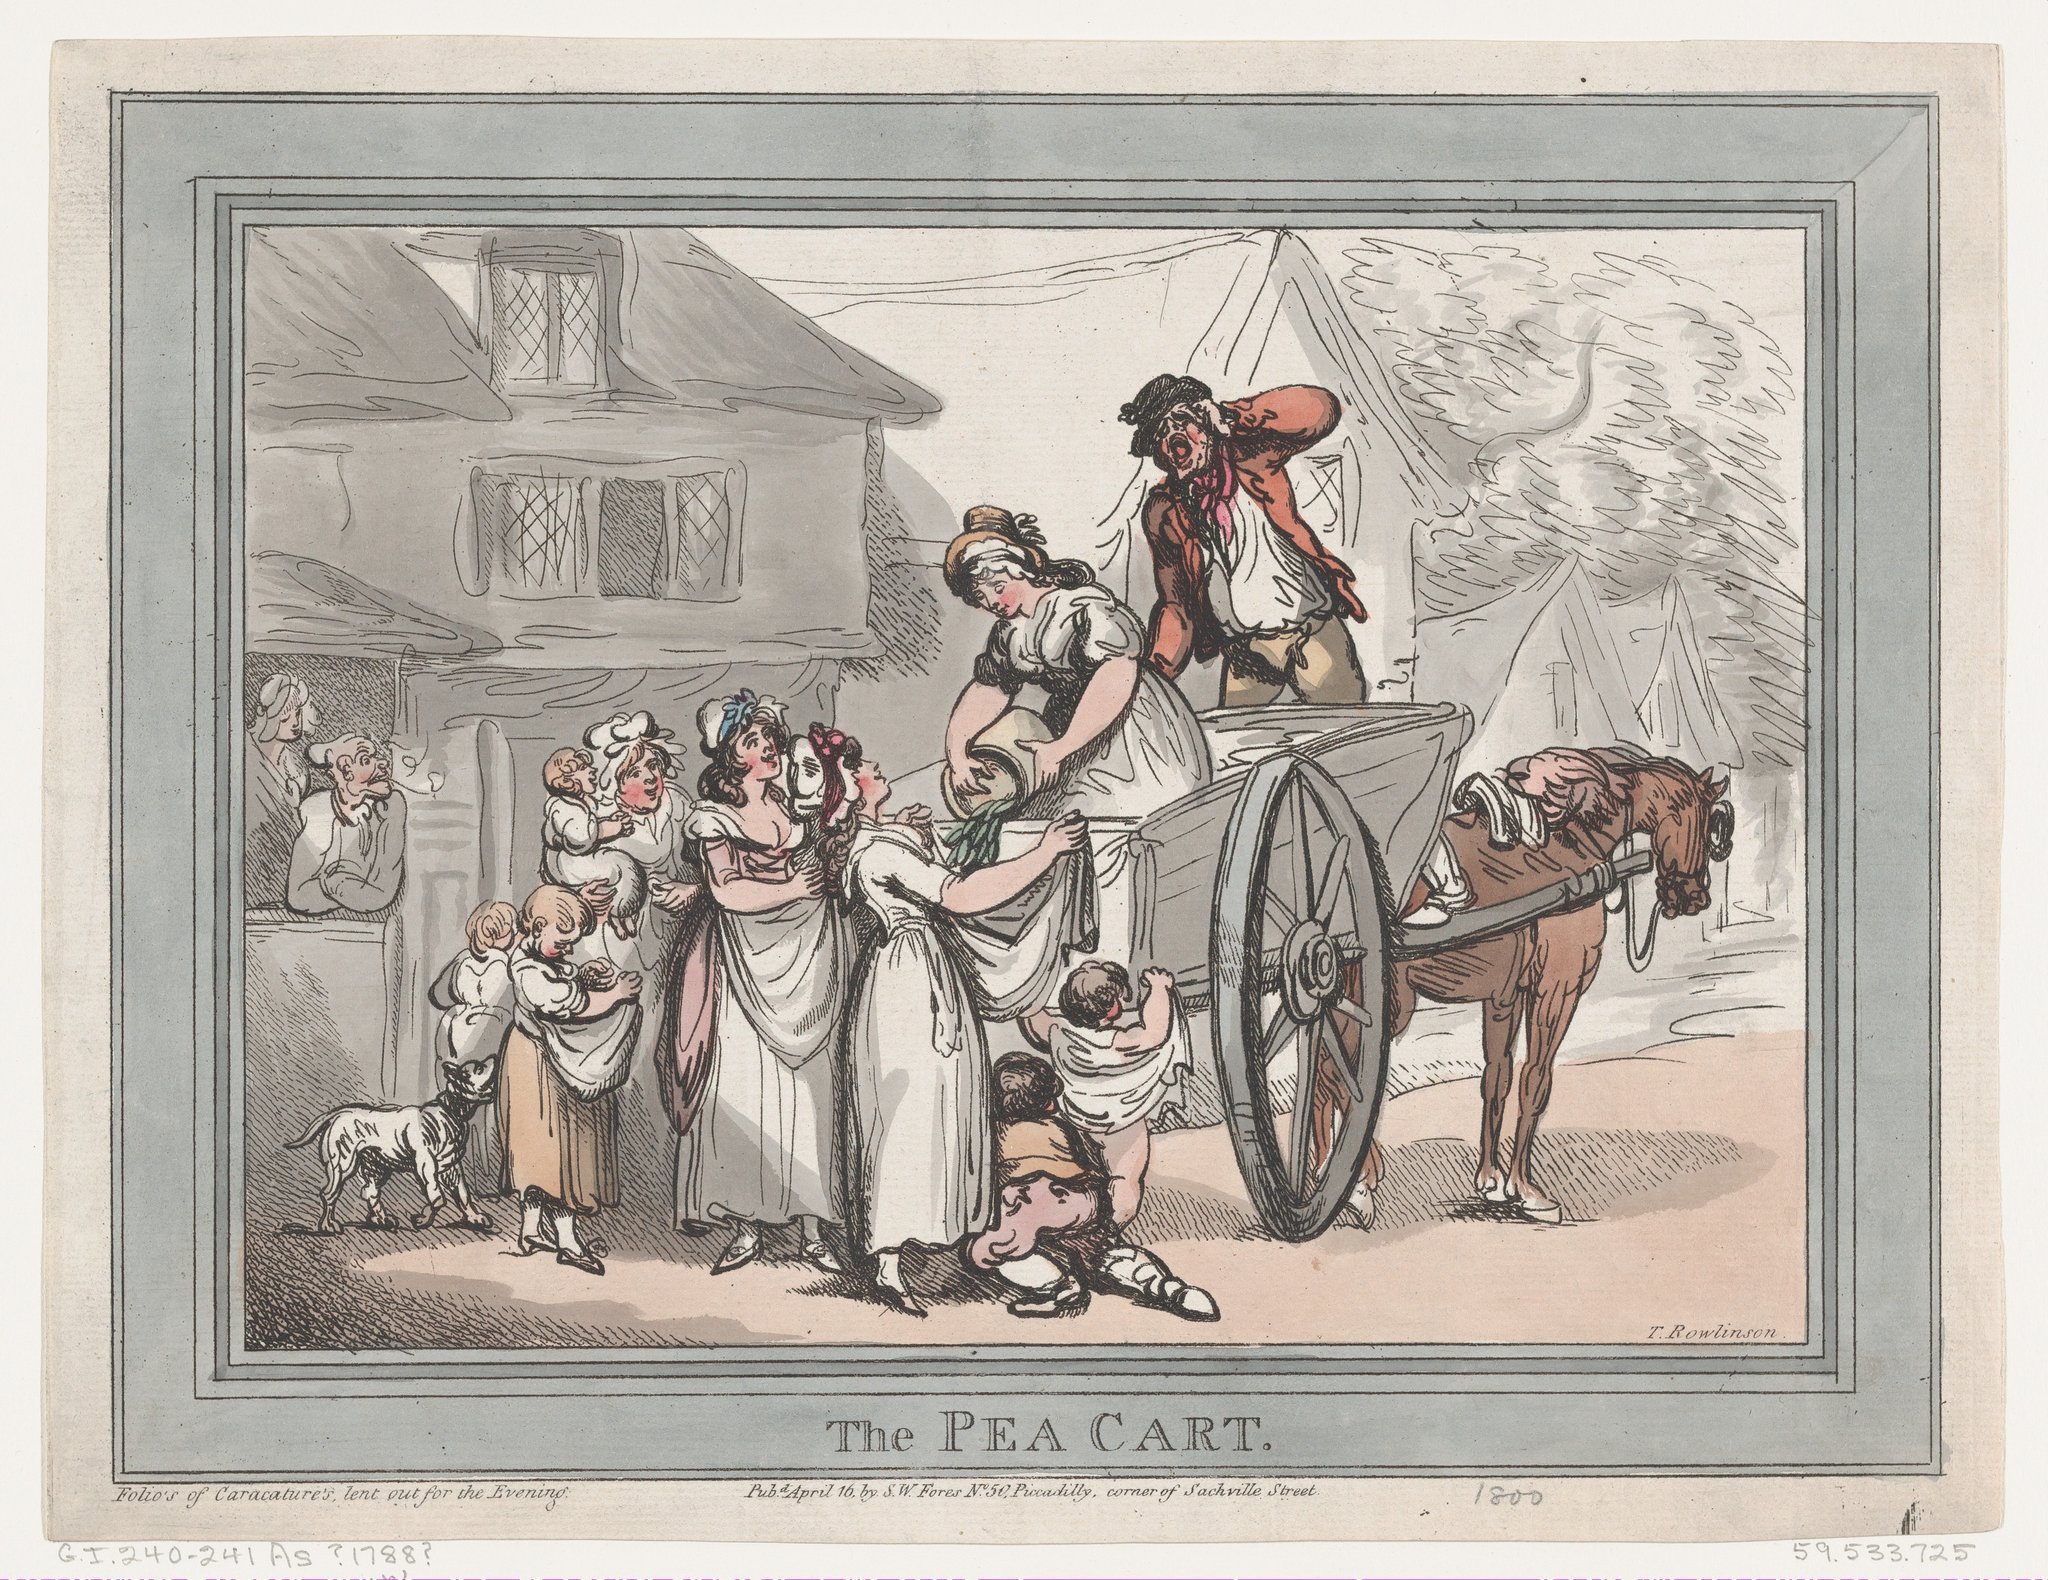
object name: print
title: The Pea Cart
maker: thomas rowlandson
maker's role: artist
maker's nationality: british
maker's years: 1757-1827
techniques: etching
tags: infants,men,women,dogs,horses